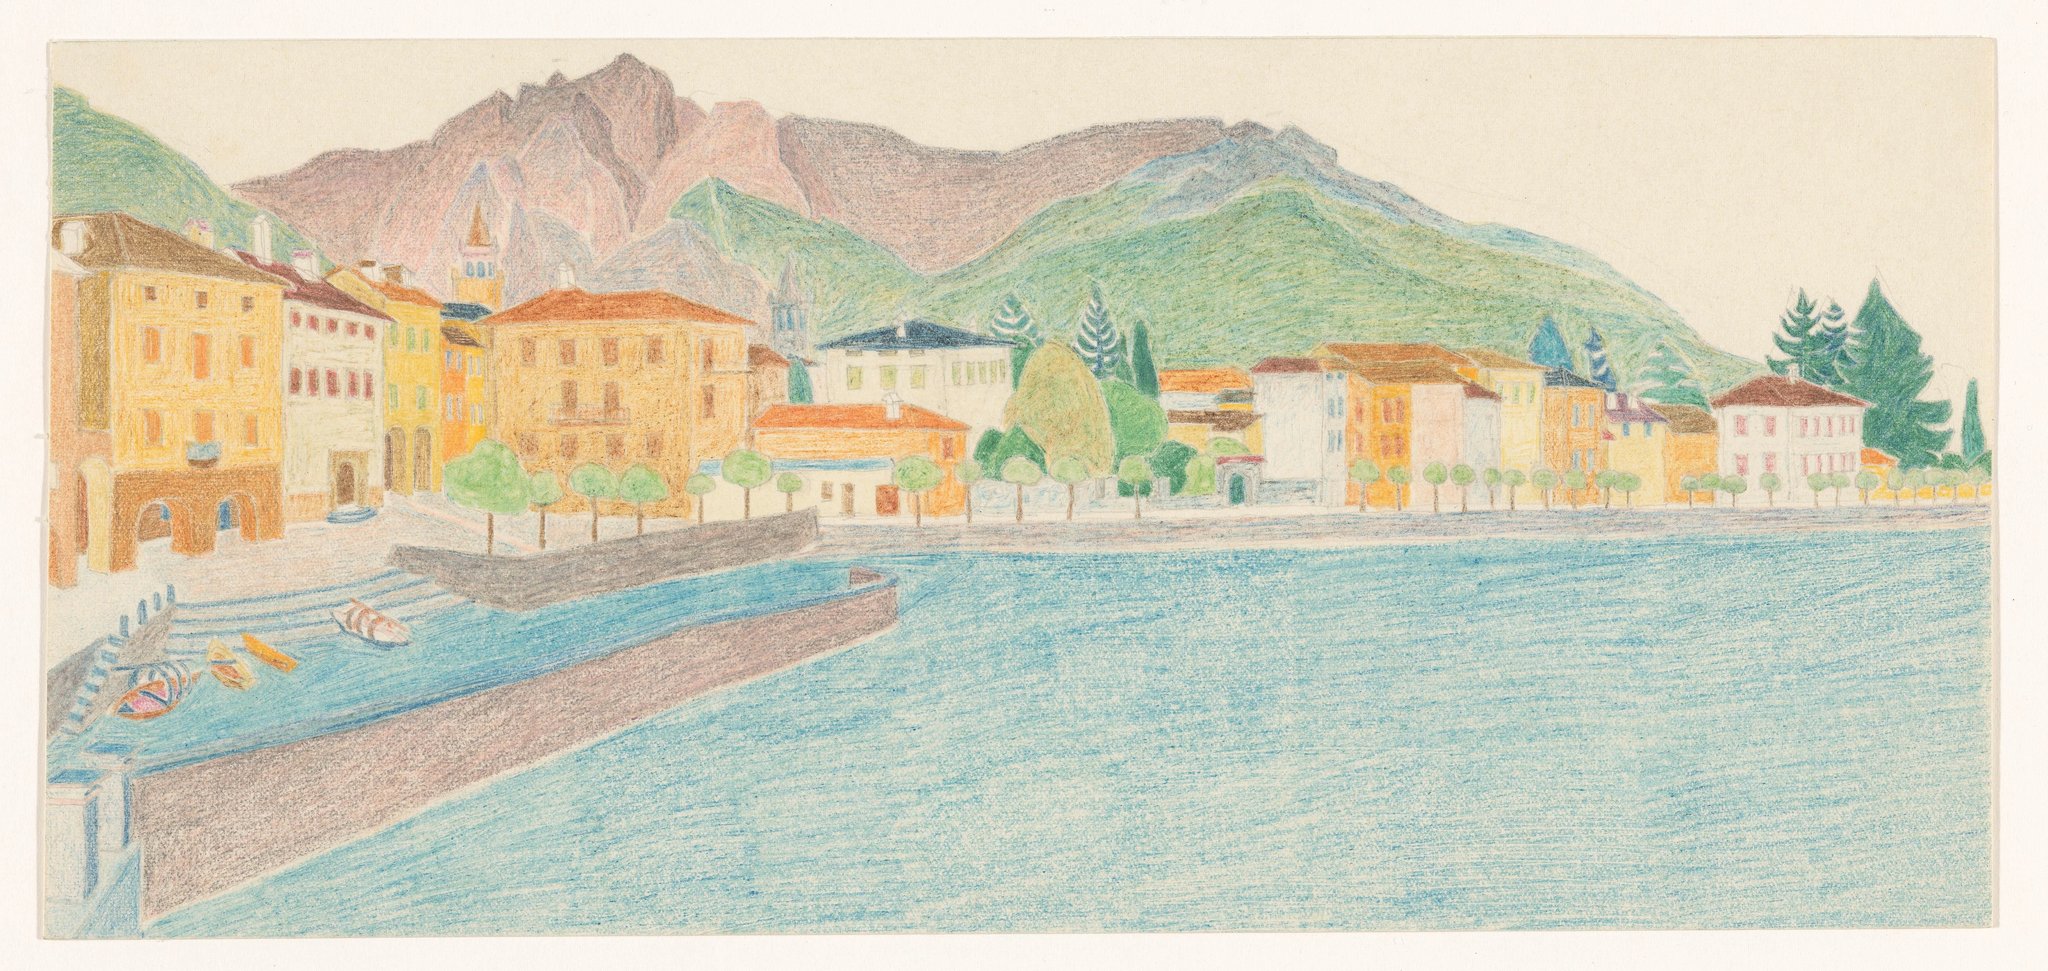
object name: drawing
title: Gezicht op een Italiaanse stad aan het water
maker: reijer stolk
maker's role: draughtsman, print maker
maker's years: 1896-1945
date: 1937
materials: chalk, paper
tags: city-view in general; 'veduta', landscapes with waters, waterscapes, seascapes (in the temperate zone), mountains, italy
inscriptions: collector's mark: Lugt 2228